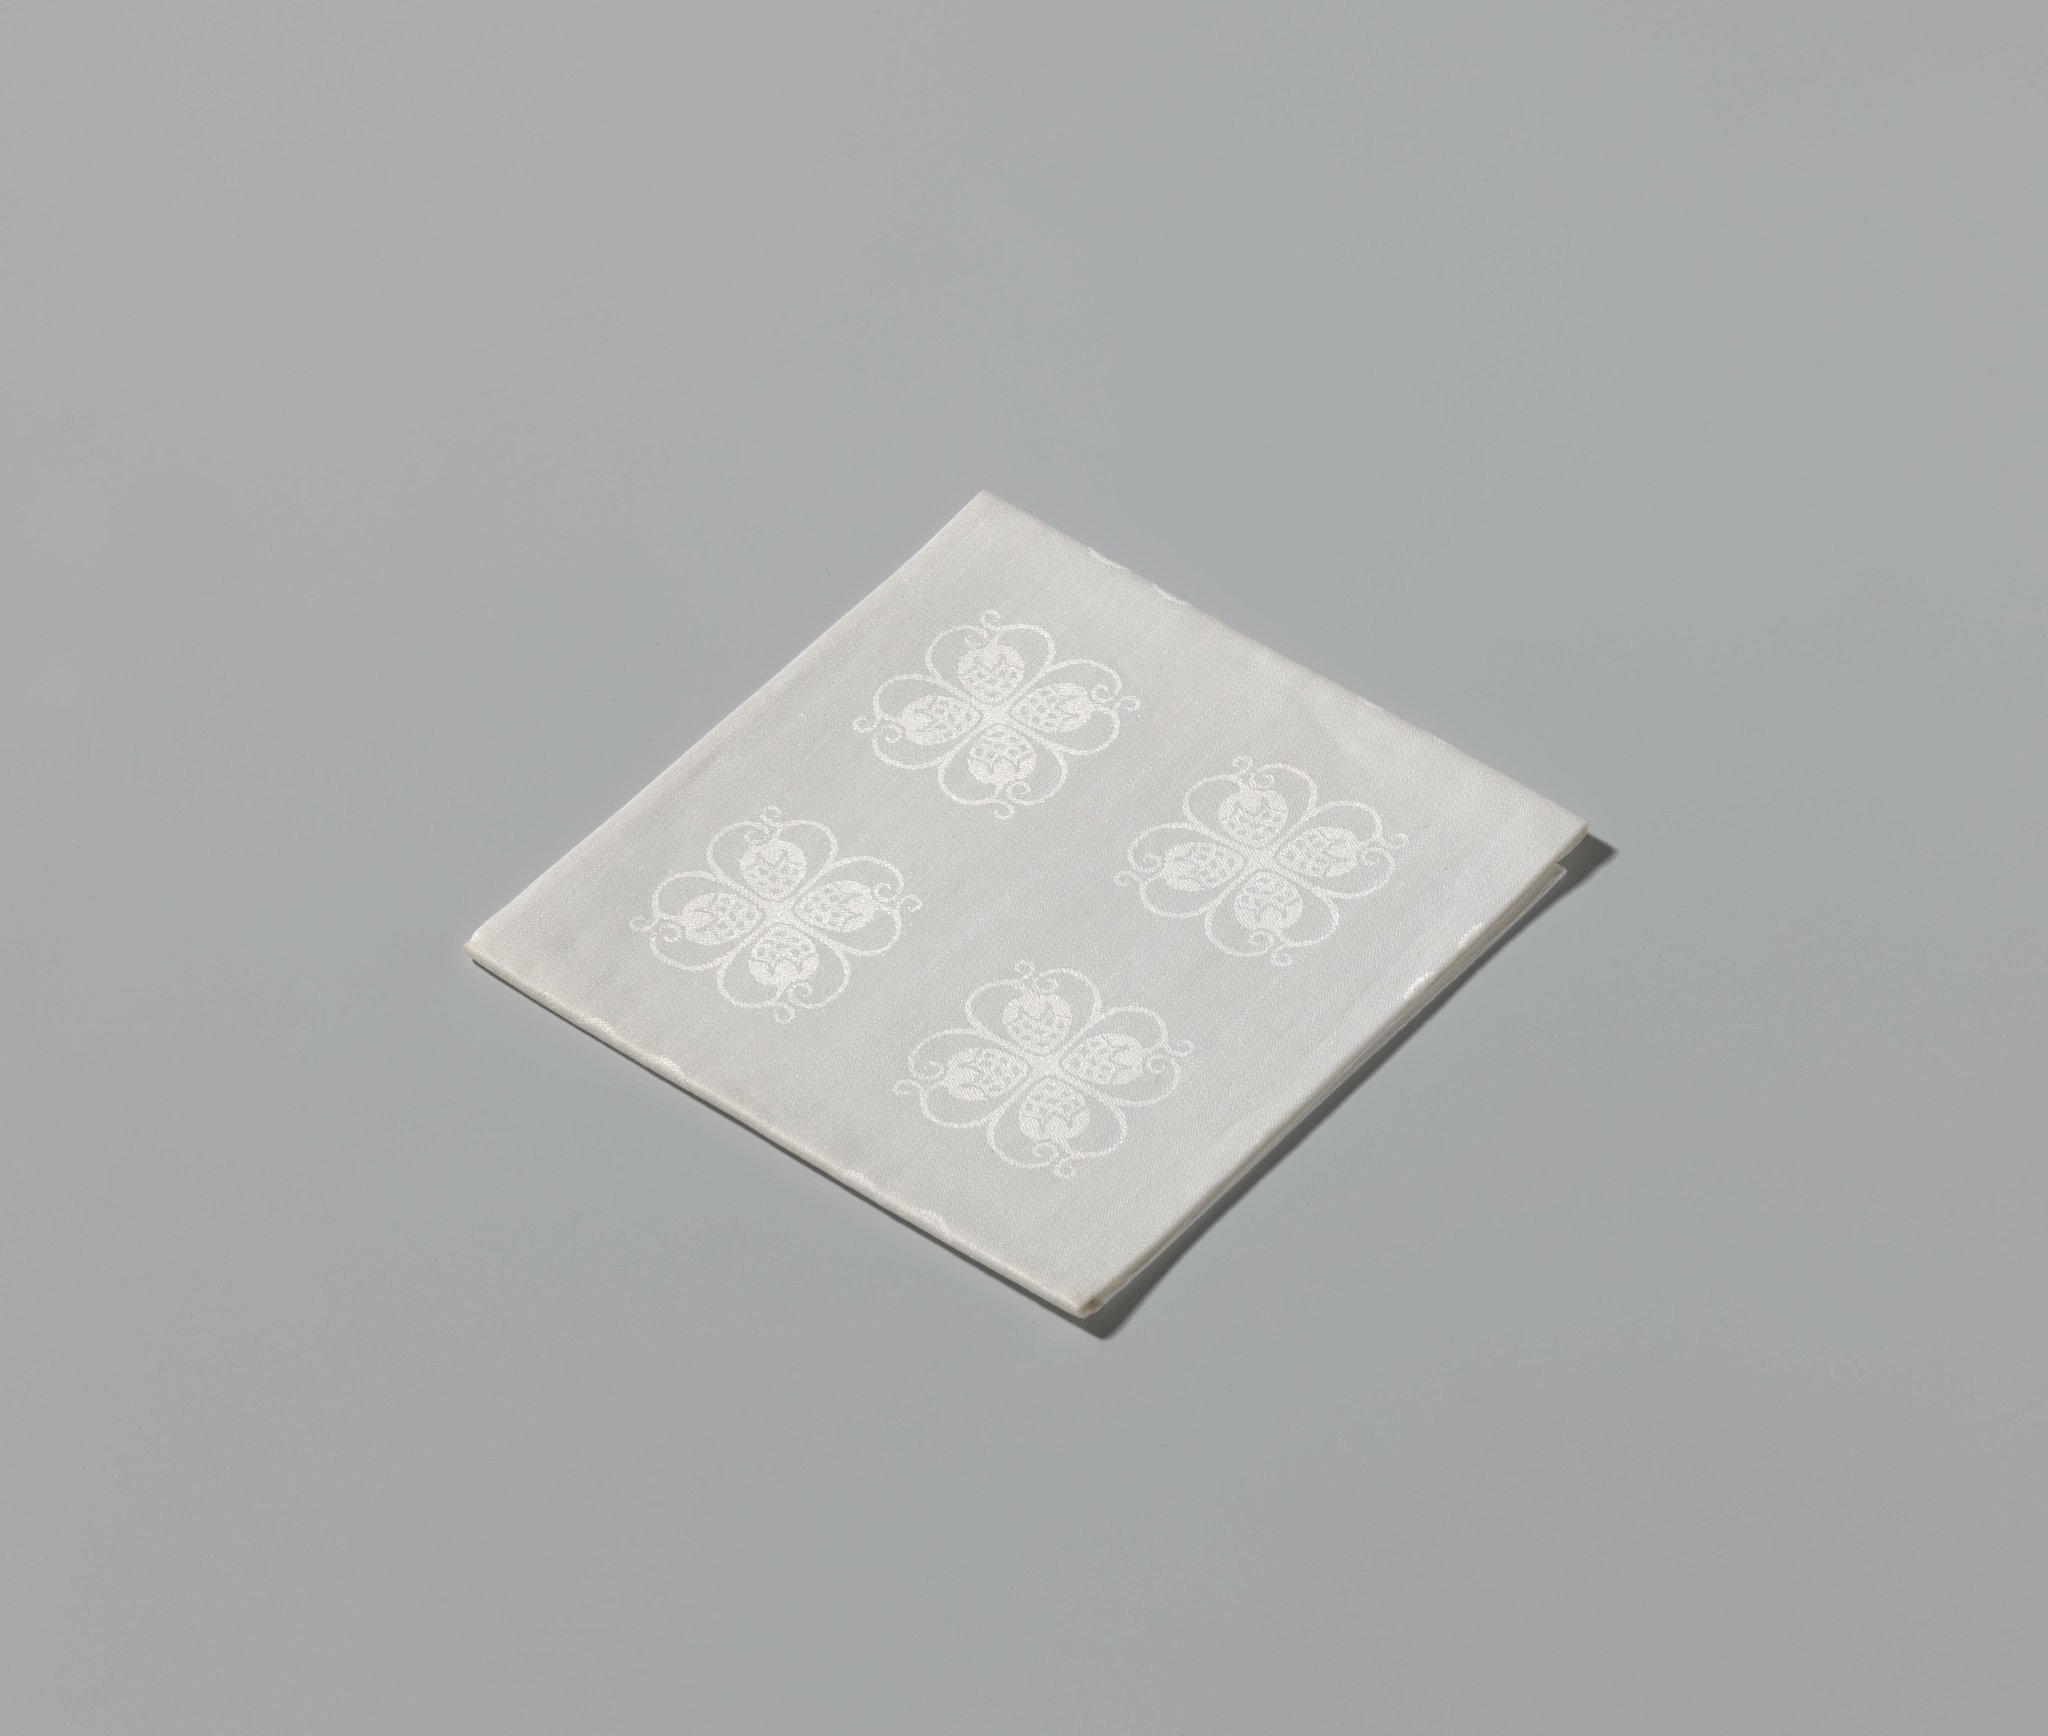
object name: napkin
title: Servet van linnendamast met aardbeien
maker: chris lebeau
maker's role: draughtsman, print maker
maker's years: 1878-1945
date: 1878-1945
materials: linen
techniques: damask, weave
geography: eindhoven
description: Servet van linnendamast met dessin nr. 602: motief aardbei. Het servet hoort bij vijf servetten (BK-1979-264-A t/m BK-1979-264-F) en een tafellaken (BK-1979-263).